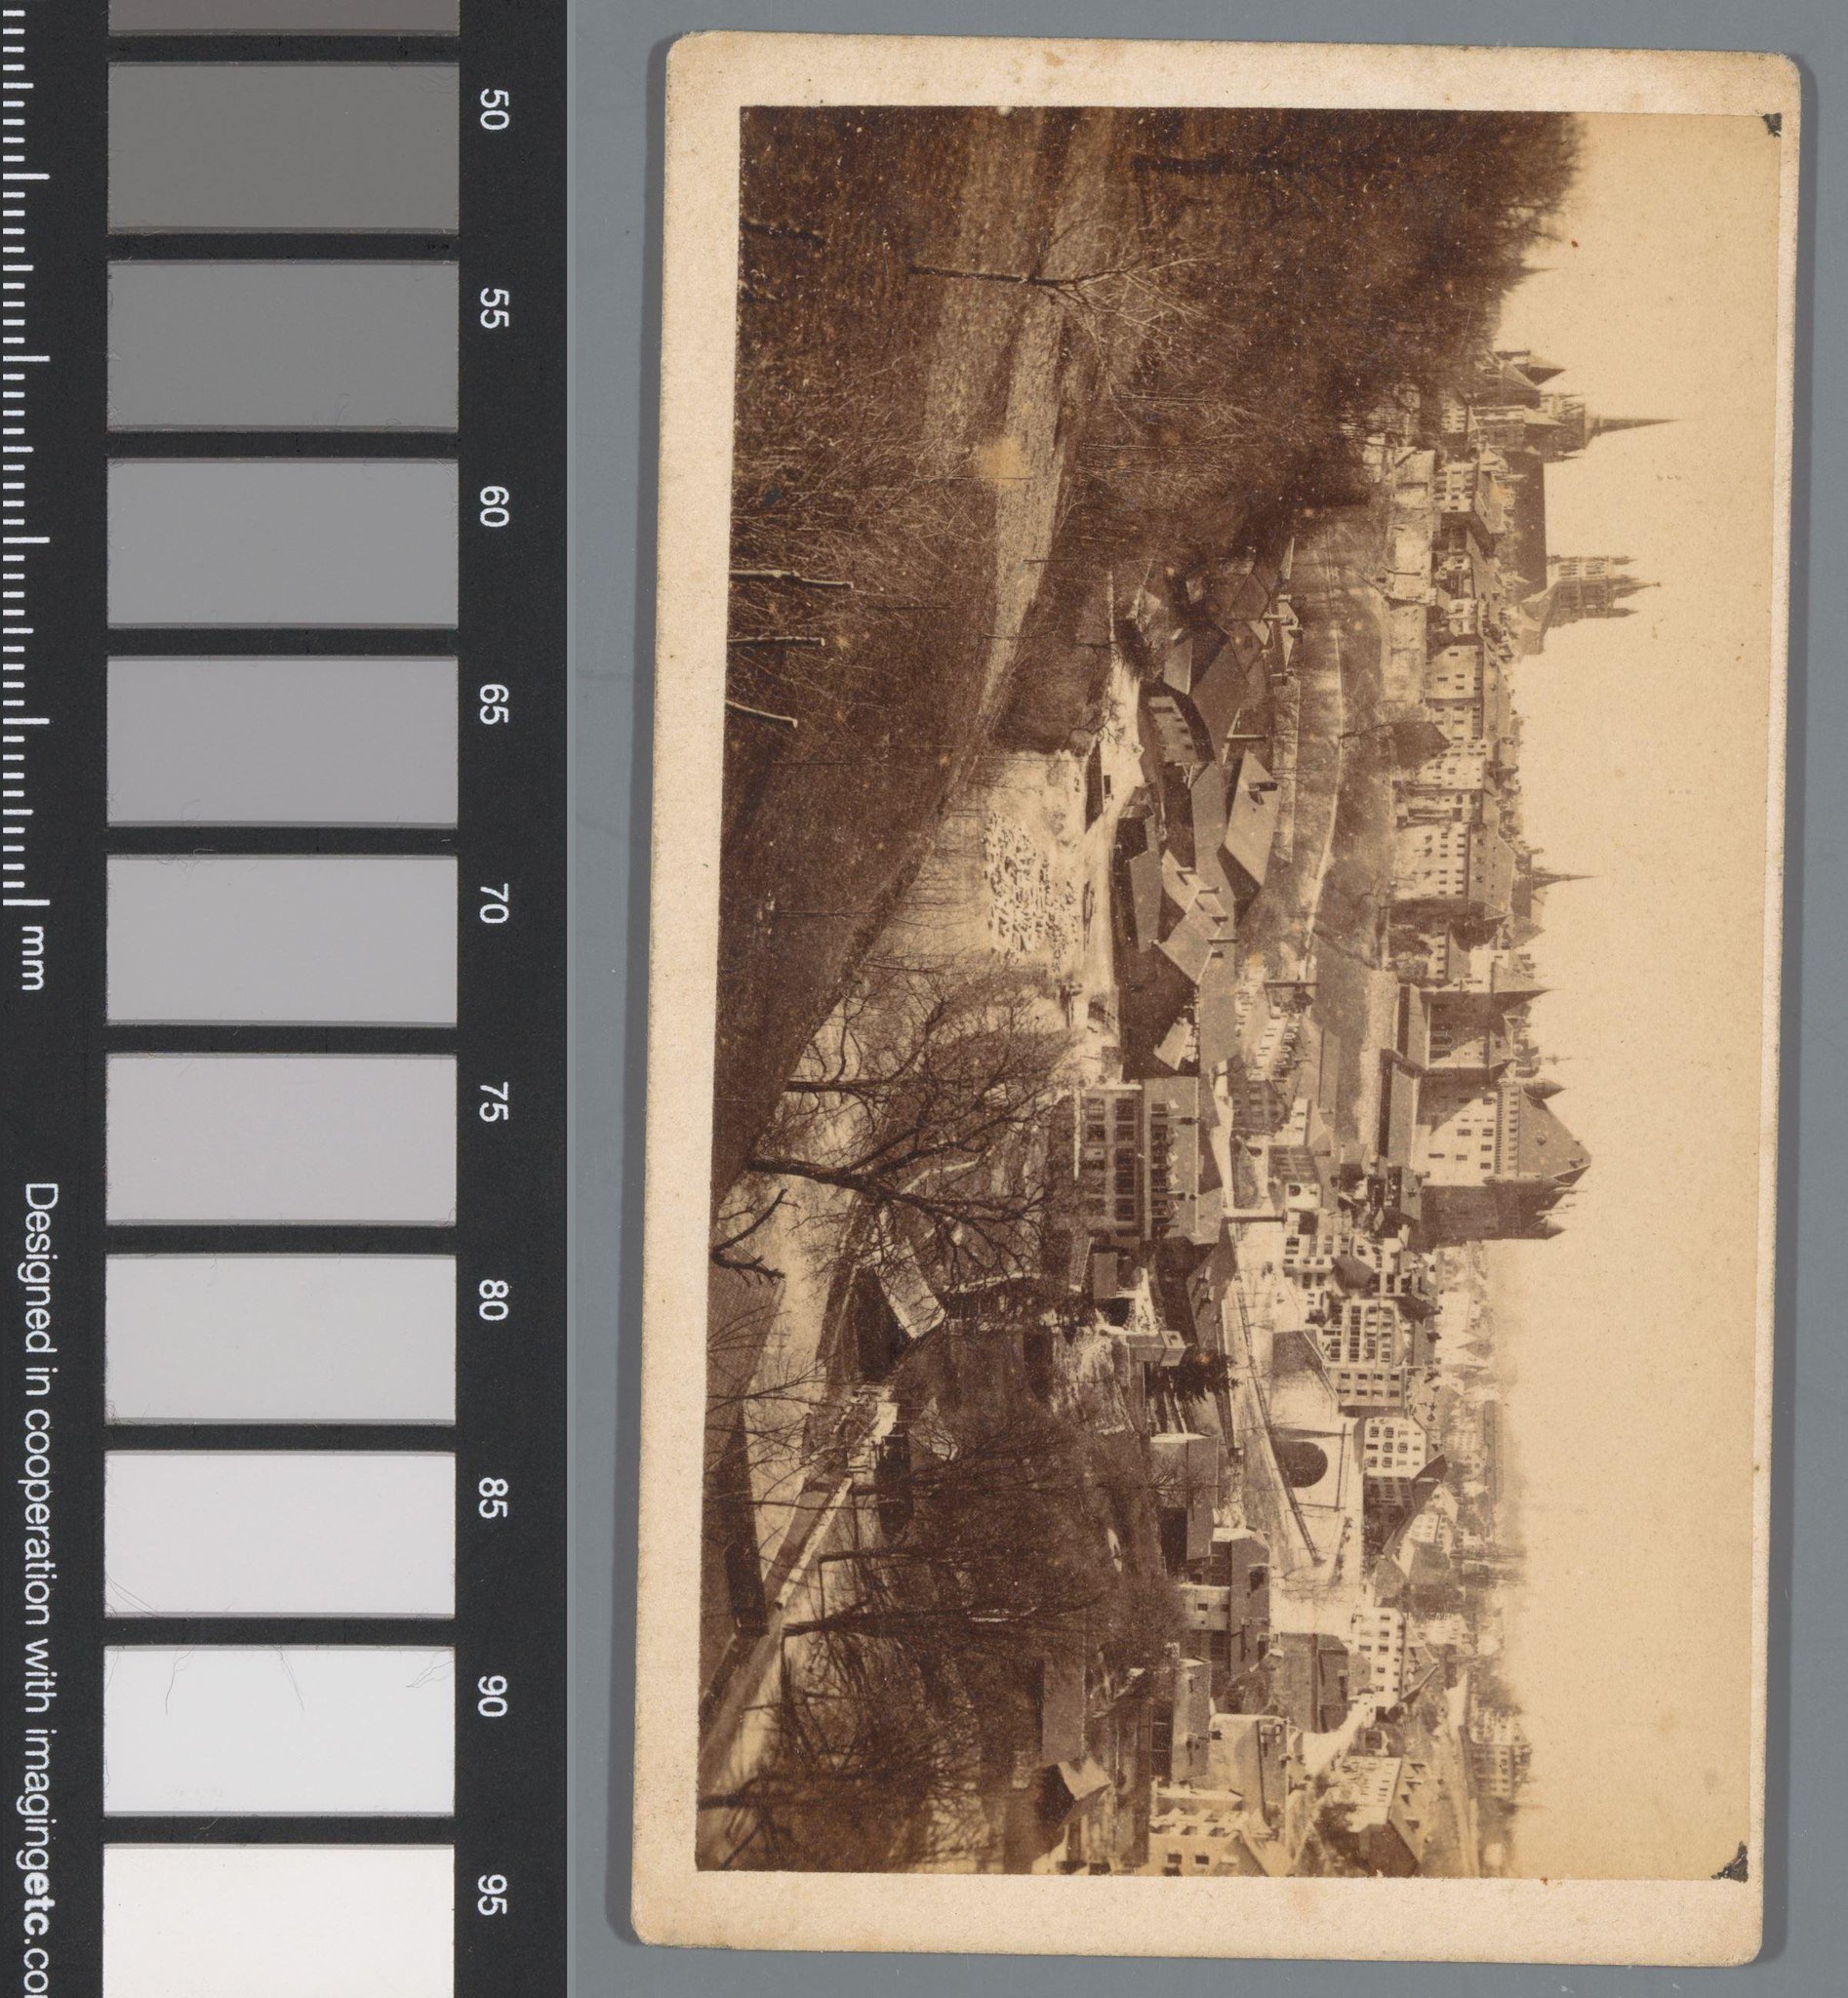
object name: photograph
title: Gezicht op Lausanne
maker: Anonymous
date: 1855-1885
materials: cardboard, paper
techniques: albumen print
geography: lausanne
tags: city-view in general; 'veduta'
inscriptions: number: ‘777’